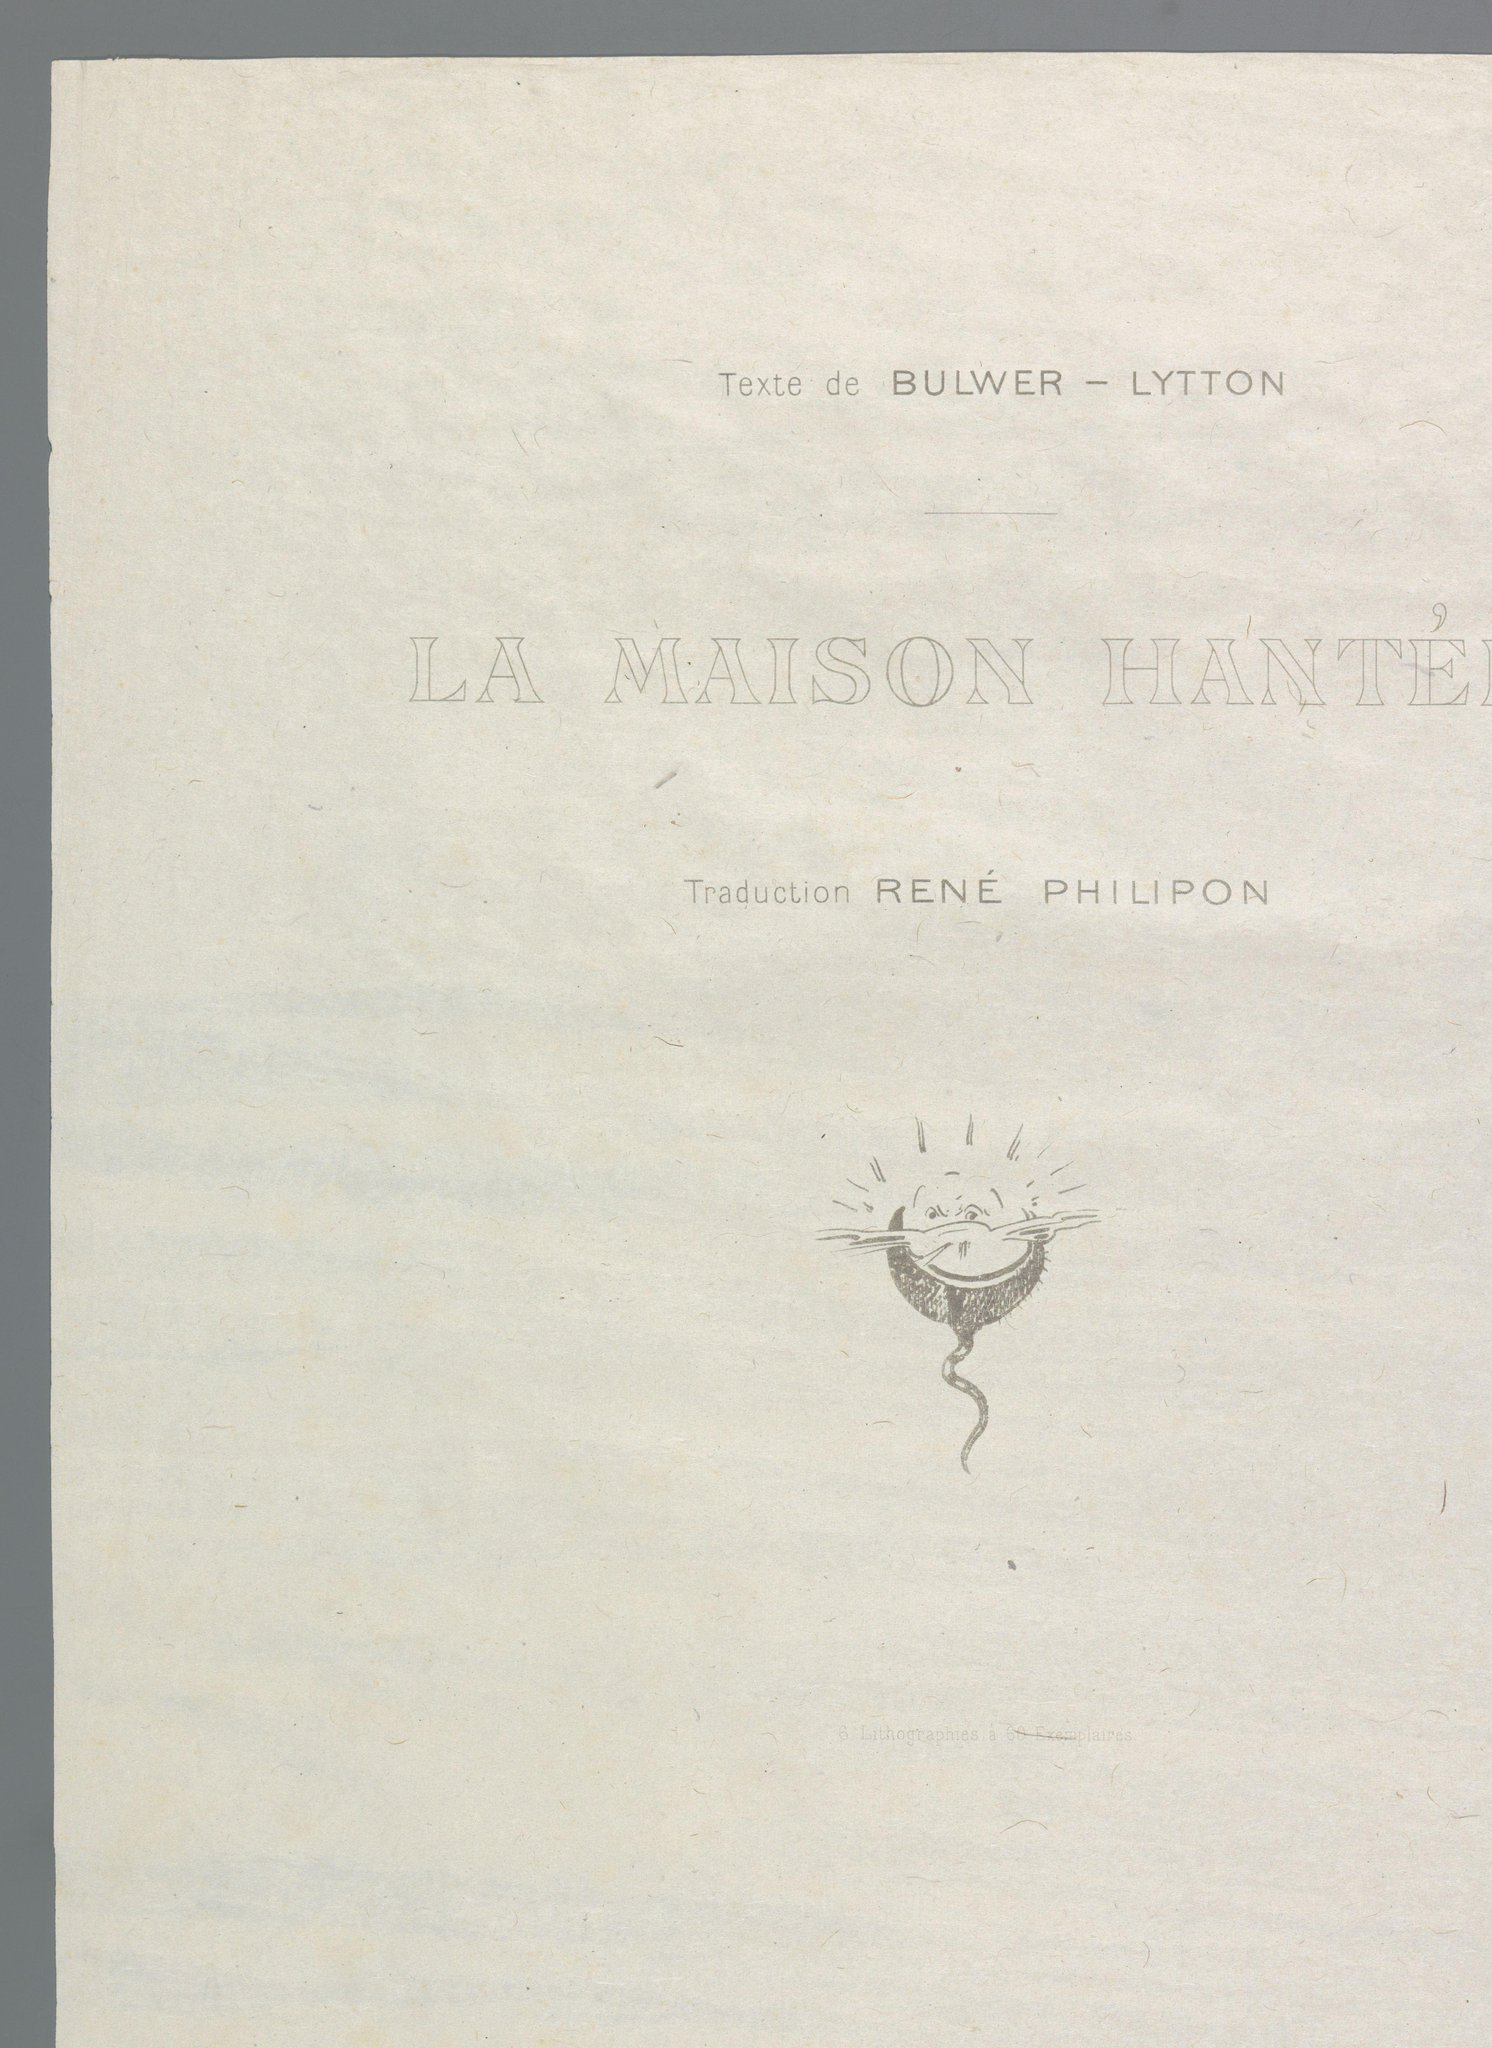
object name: print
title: Het Spookhuis, "La Maison Hantée", illustraties bij tekst van Bulwer-Lytton, in het frans vertaald door René Philipon,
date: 1896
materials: paper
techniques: lithograph